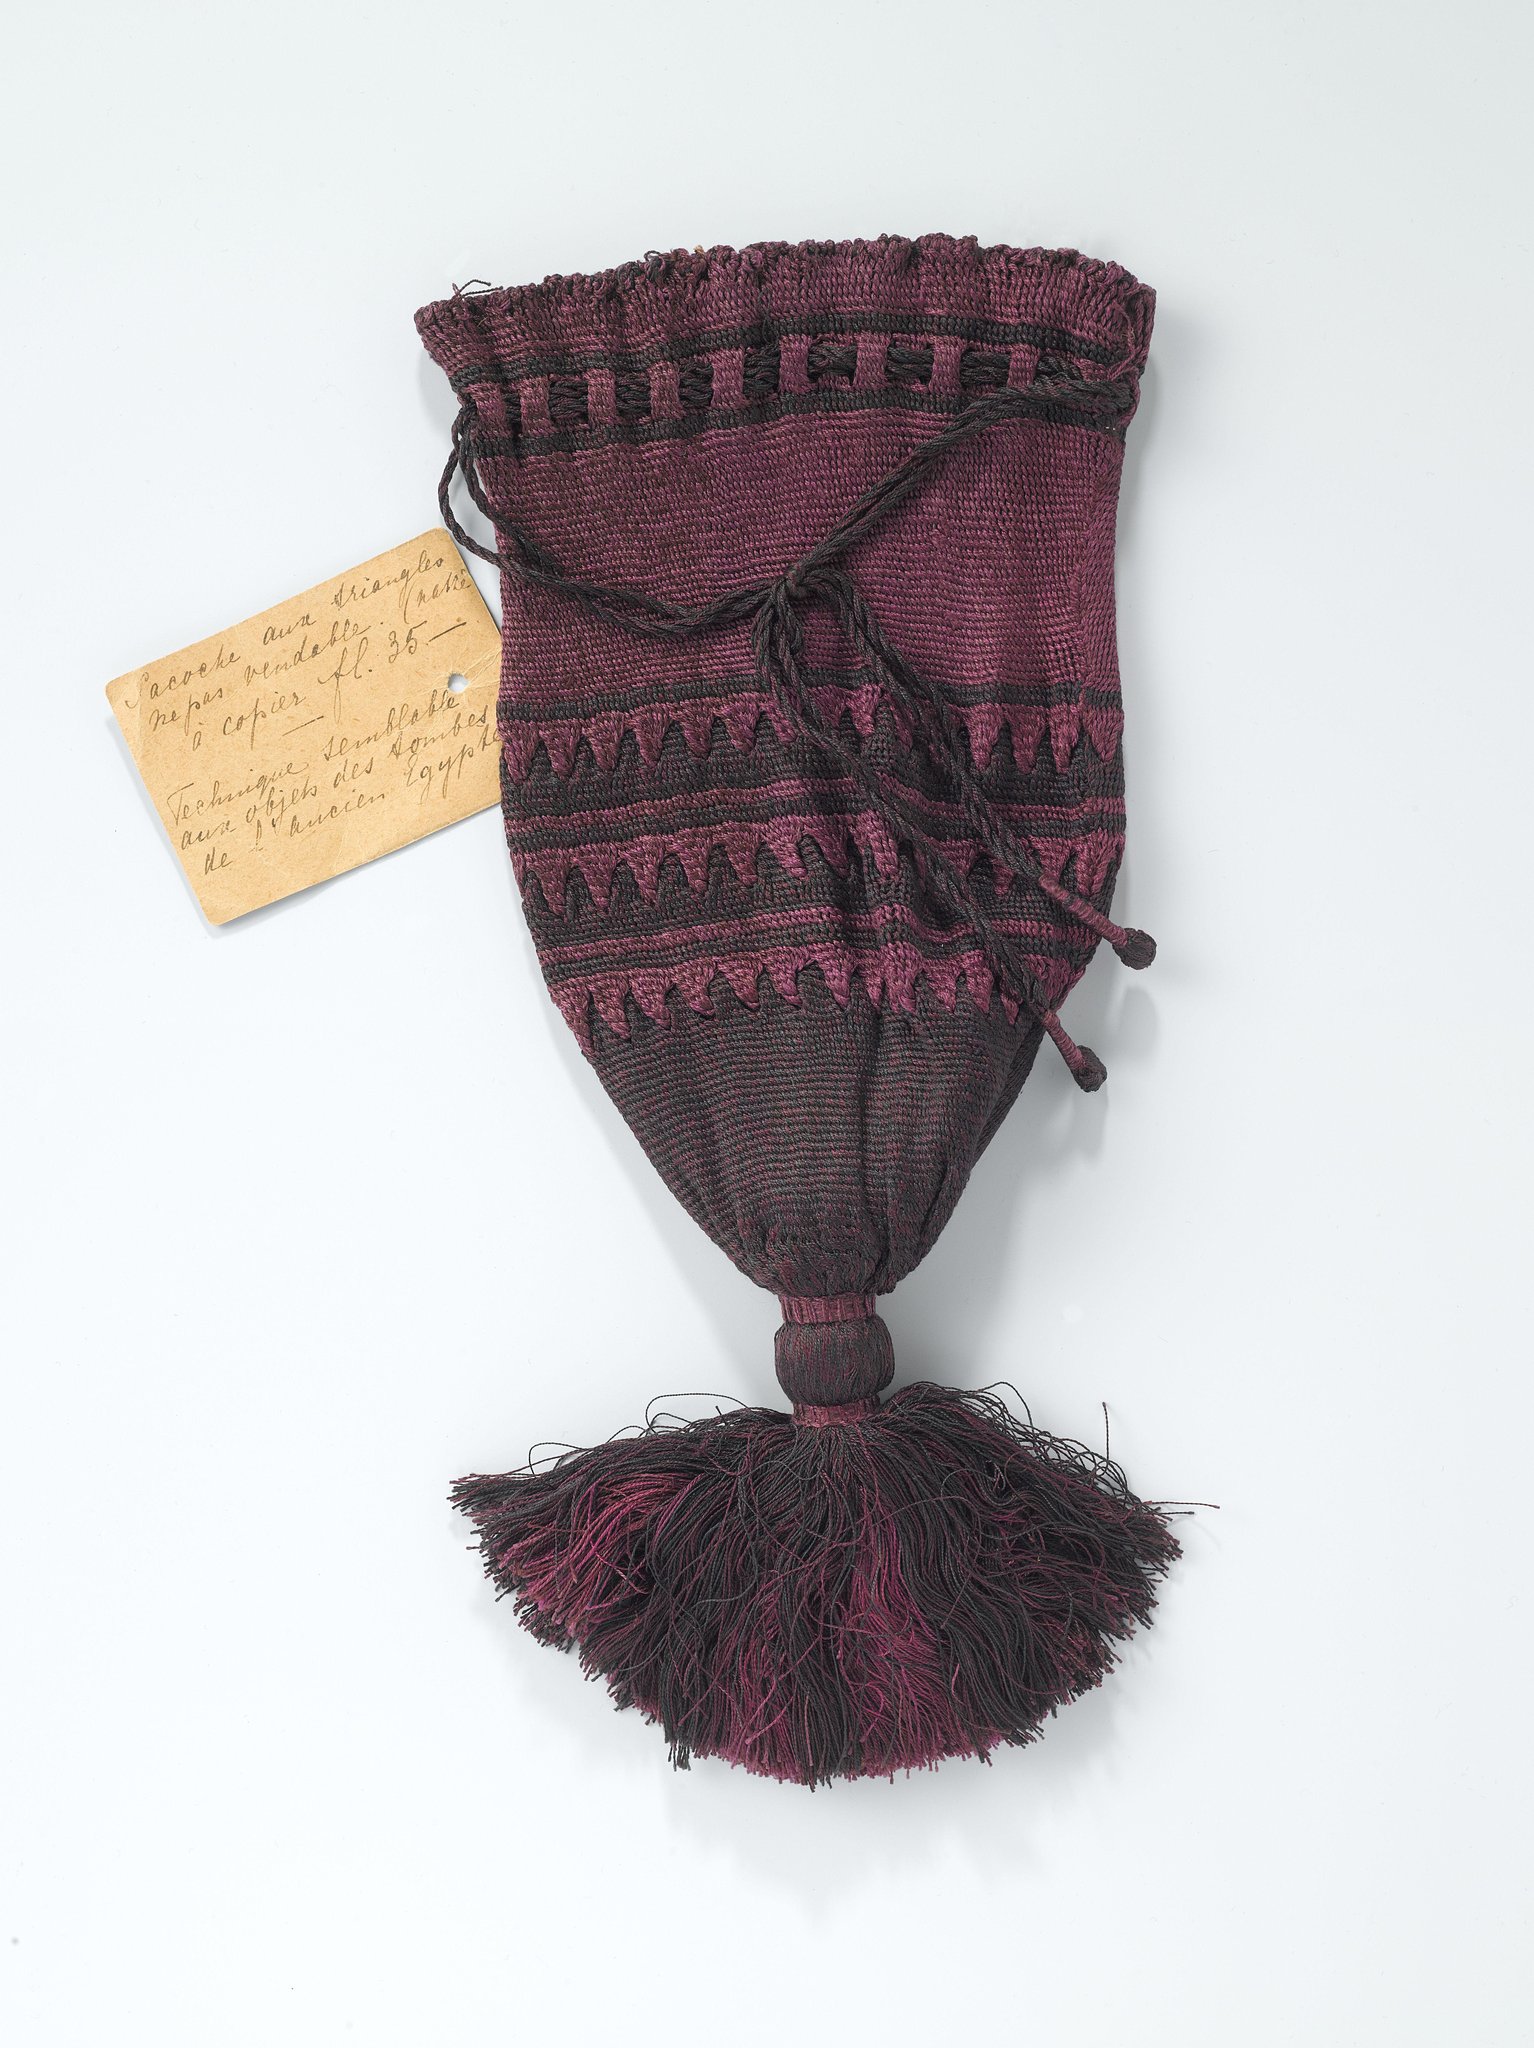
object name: purse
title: Buidel van zwarte en paarse zijde, uitgevoerd in Egyptisch vlechtwerk (sprang)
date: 1922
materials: silk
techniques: sprang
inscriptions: circumscription: ‘Buidel van zwarte en paarse zijde uitgevoerd in 'Egytpisch vlechtwerk'. Gemaakt door mw. Sieverts van Reesema voor de Wereldtentoonstelling te Parijs in 1925. Nederland 1925.’, circumscription: ‘Sacoche aux triangles. Ne pas vendable. Technique semblable aux objets des tombes de l’Ancien Egypte./Pour l’exposition à Paris 1925, Section Néerlandaise, VI/1470/Collection E.S. van Reesema en possession de l’Institution d’Arts & Métiers, la Haye, Hollande.’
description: Buidel van zwarte en paarse zijde, in Egyptisch vlechtwerk (sprang) uitgevoerd. Langs twee kanten loopt een naad. De buidel vormt aan de onderkant een afgerond uiteinde, waarbij de zwarte en paarse draden, via een knot, samenkomen in een kwast. Langs de bovenrand zijn twee dubbele gedraaide koorden geregen. De buidel is ongevoerd.